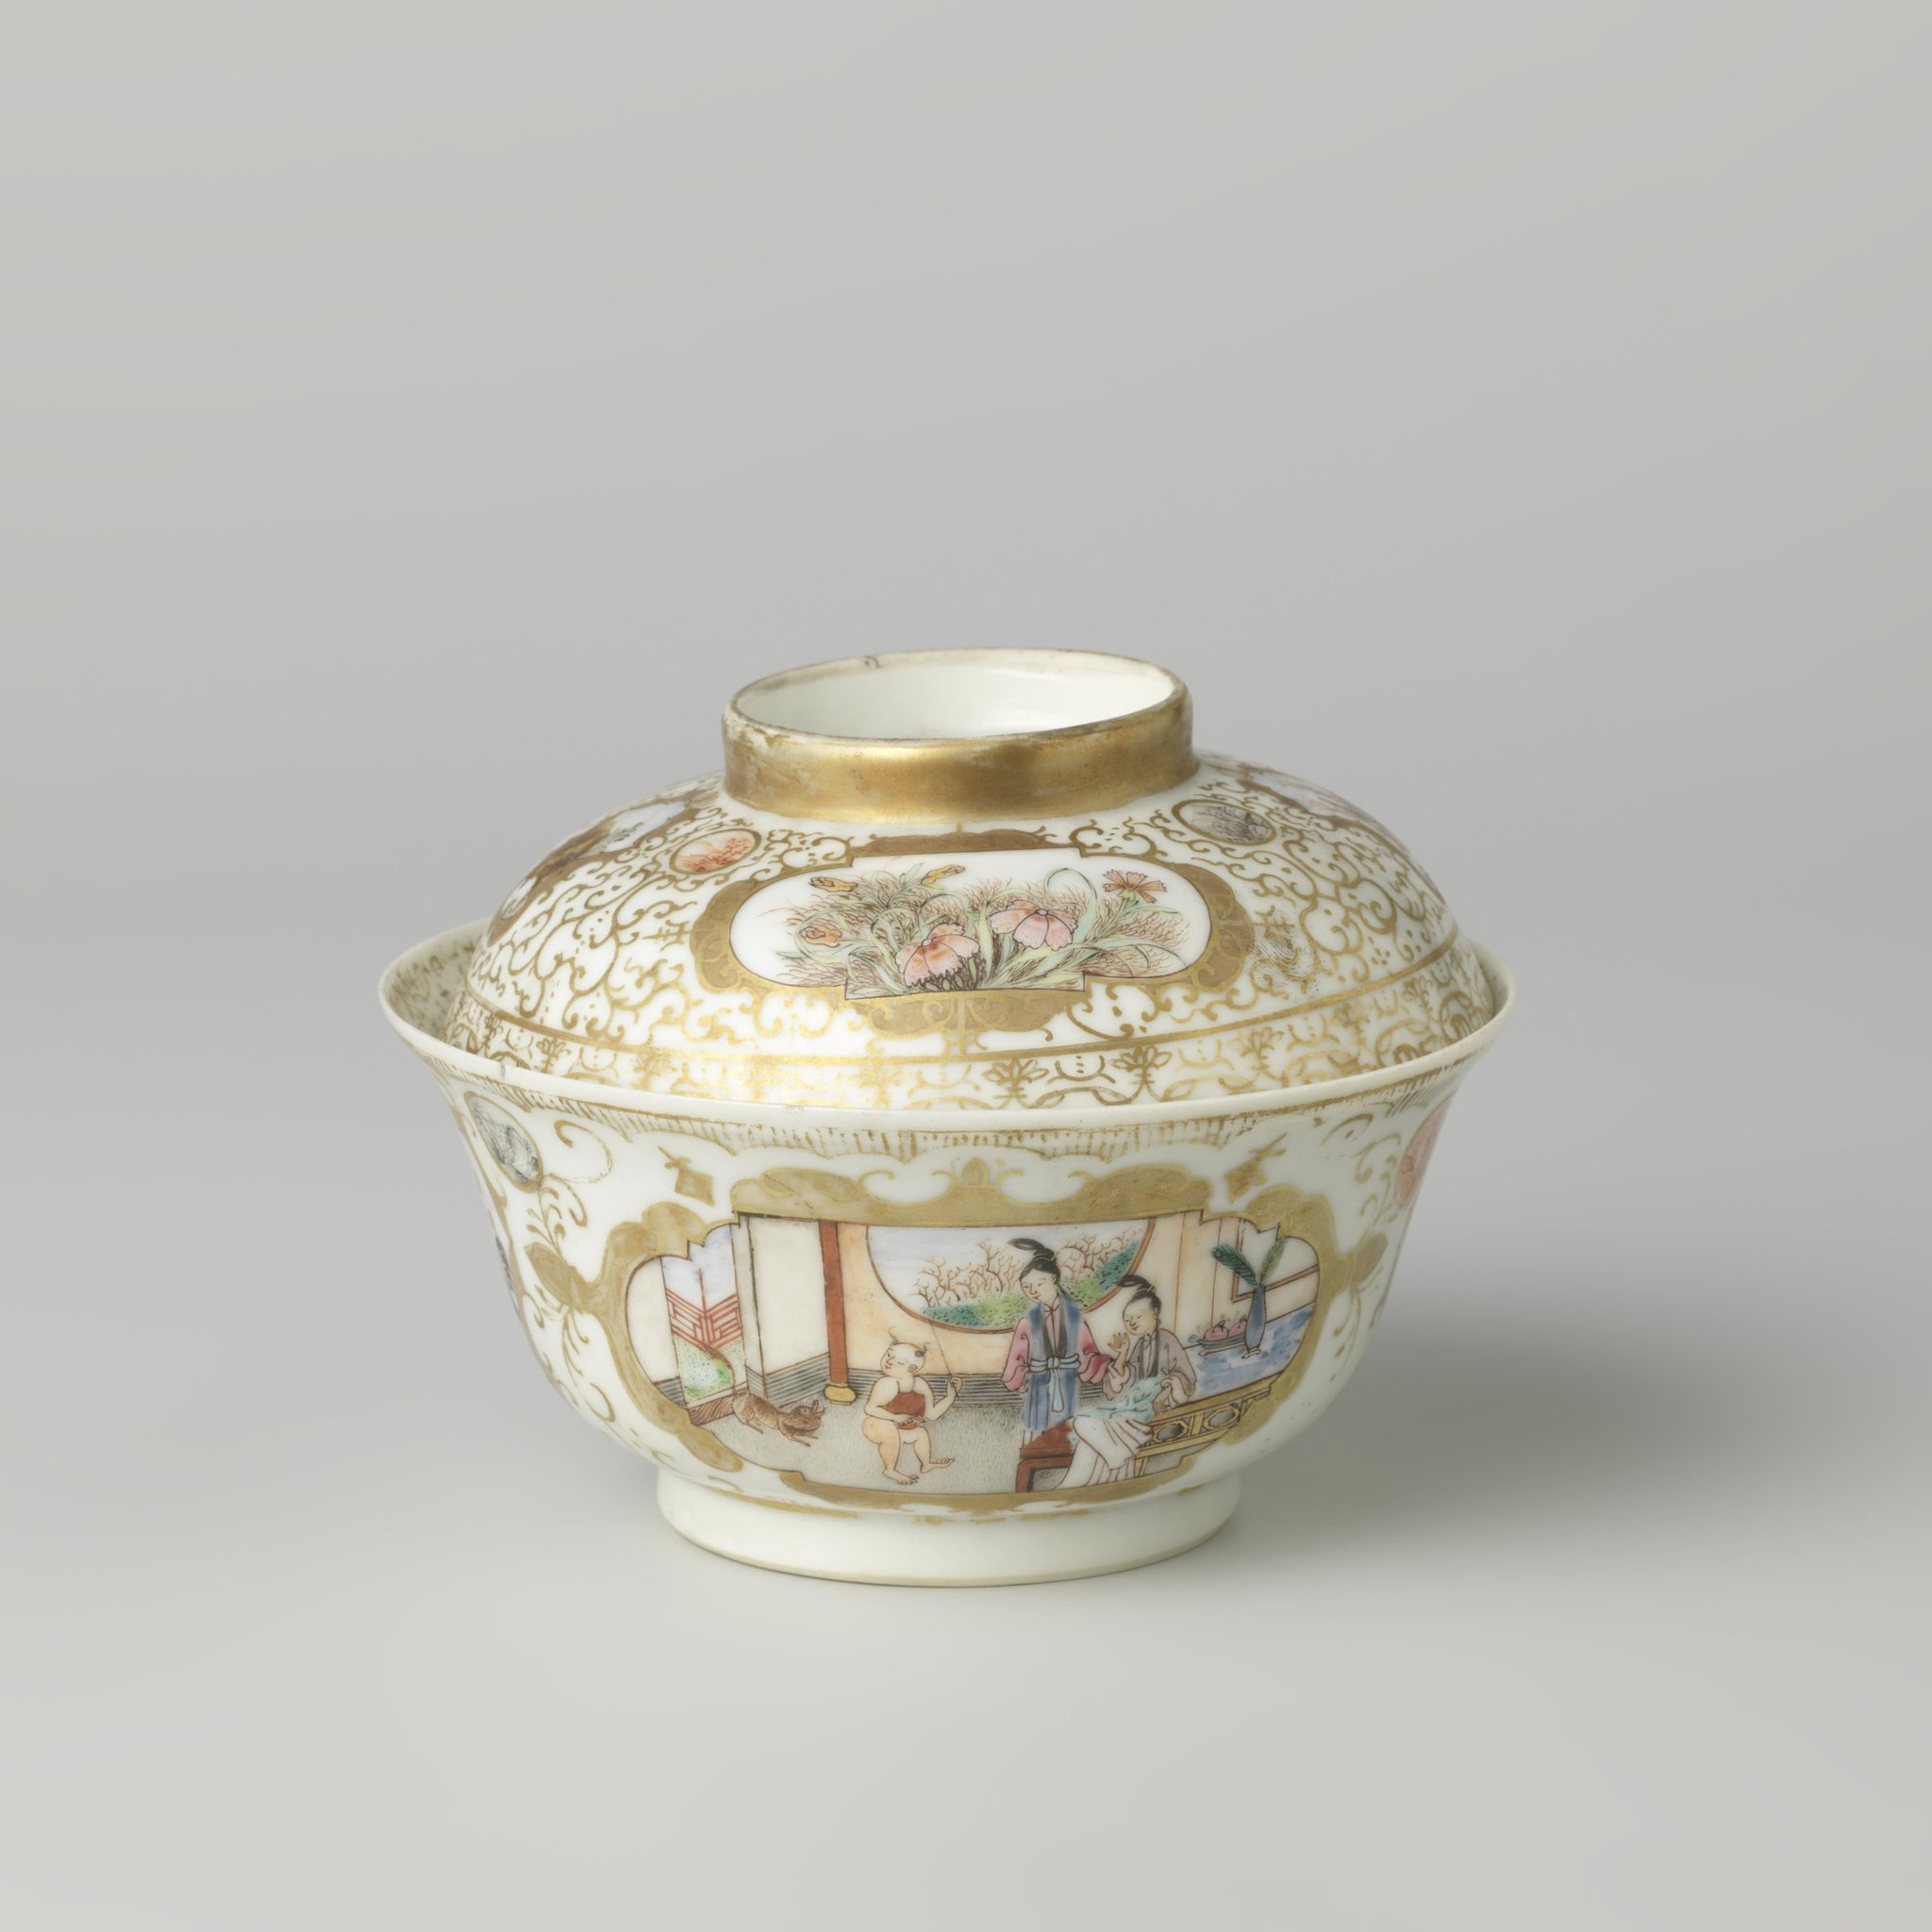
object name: platter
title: Saucer with women, birds and landscapes in panels amid scrolls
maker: Anonymous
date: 1740-1760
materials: glaze, gold, paint, porcelain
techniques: firing, gilding, turning, vitrification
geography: china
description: Schotel, versierd met cartouches waarin huiselijke scènes, afgewisseld met een haan en vogel. In de kleuren goud en polychroom.